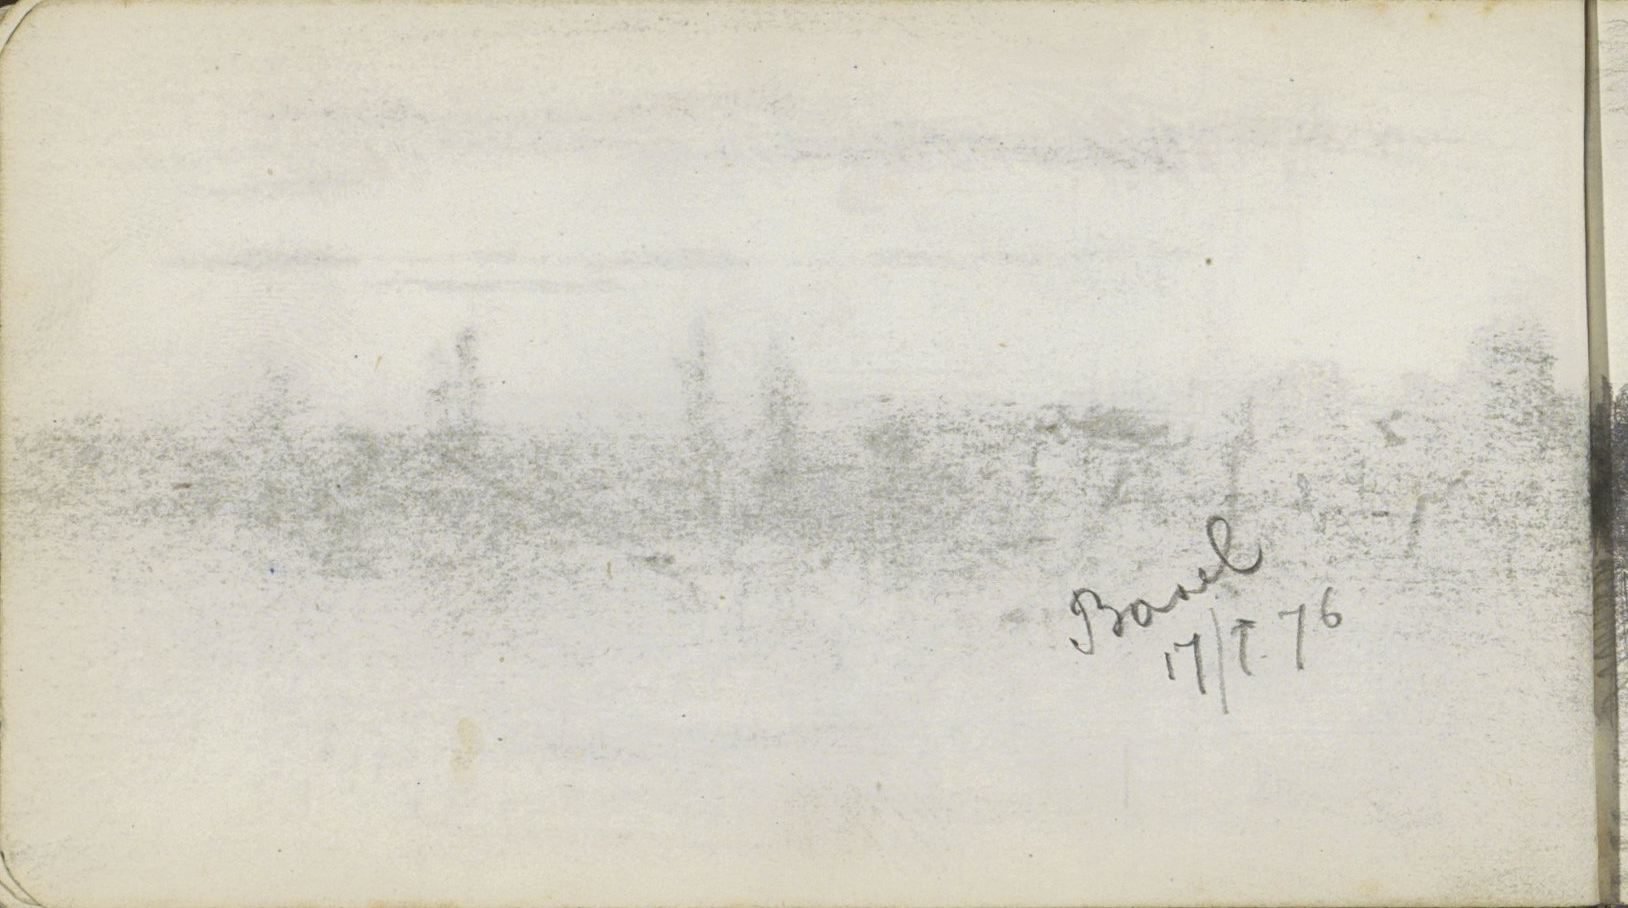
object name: sketchbook leaf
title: Notitie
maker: geo poggenbeek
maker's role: draughtsman, painter, print maker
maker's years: 1853-1903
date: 1807-1876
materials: paper, pencil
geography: basel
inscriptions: date and inscription: ‘Basel/ 17/7 76’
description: Blad 50 verso uit een schetsboek met 69 bladen.